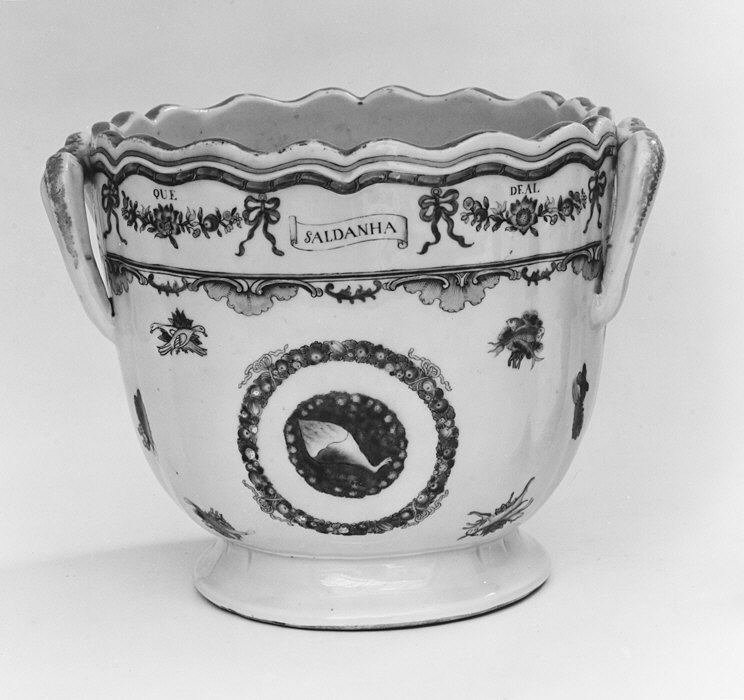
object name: jardinière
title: Jardinière (part of a service)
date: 1765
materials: hard paste porcelain